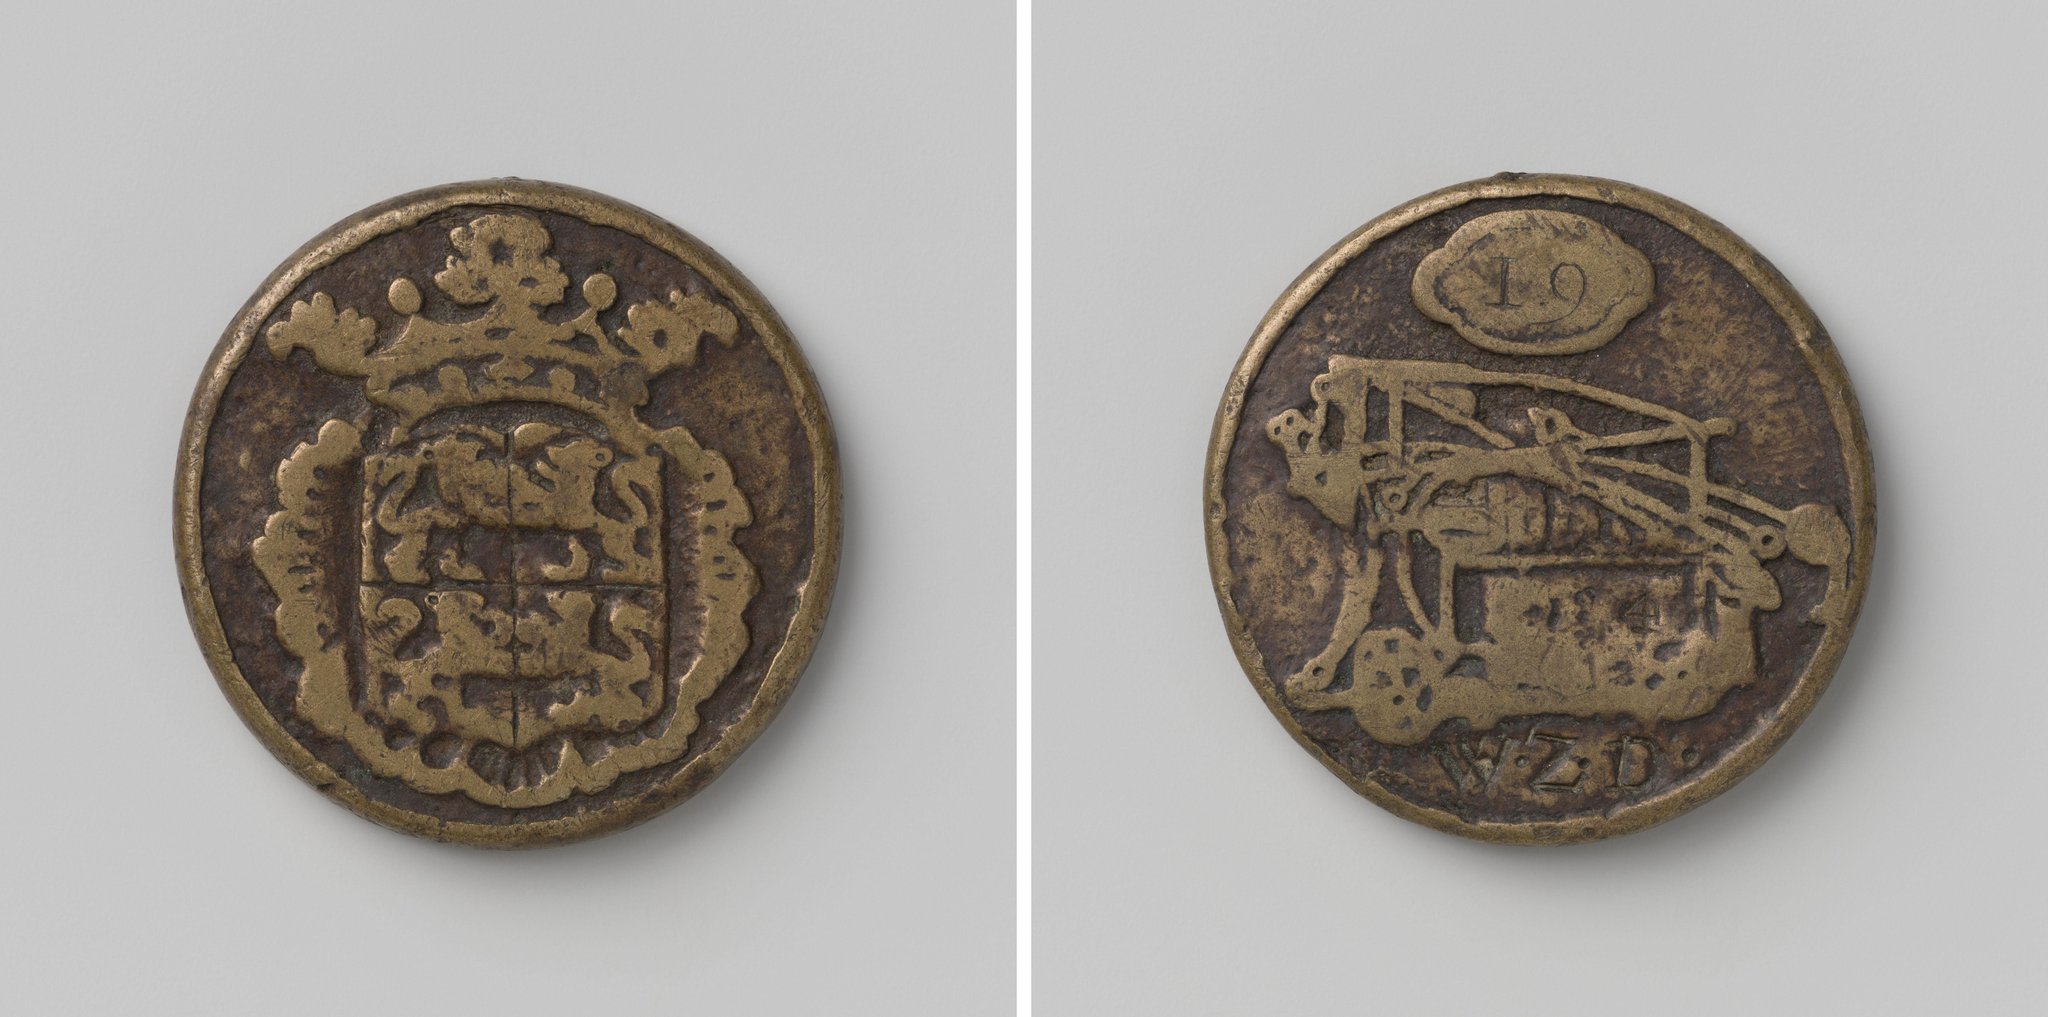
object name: fire engine medal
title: Schoonhoven, brandspuitpenning van spuit 4 met no. 19 en W.Z.D.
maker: Anonymous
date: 1680-1800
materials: brass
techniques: casting, engraving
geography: schoonhoven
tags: schoonhoven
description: Messing penning. Voorzijde: gekroond wapenschild in cartouche. Keerzijde: rijdende brandspuit boven opschrift W.Z.D. en cartouche met cijfer 19; op zijde van brandspuit: cijfer 4